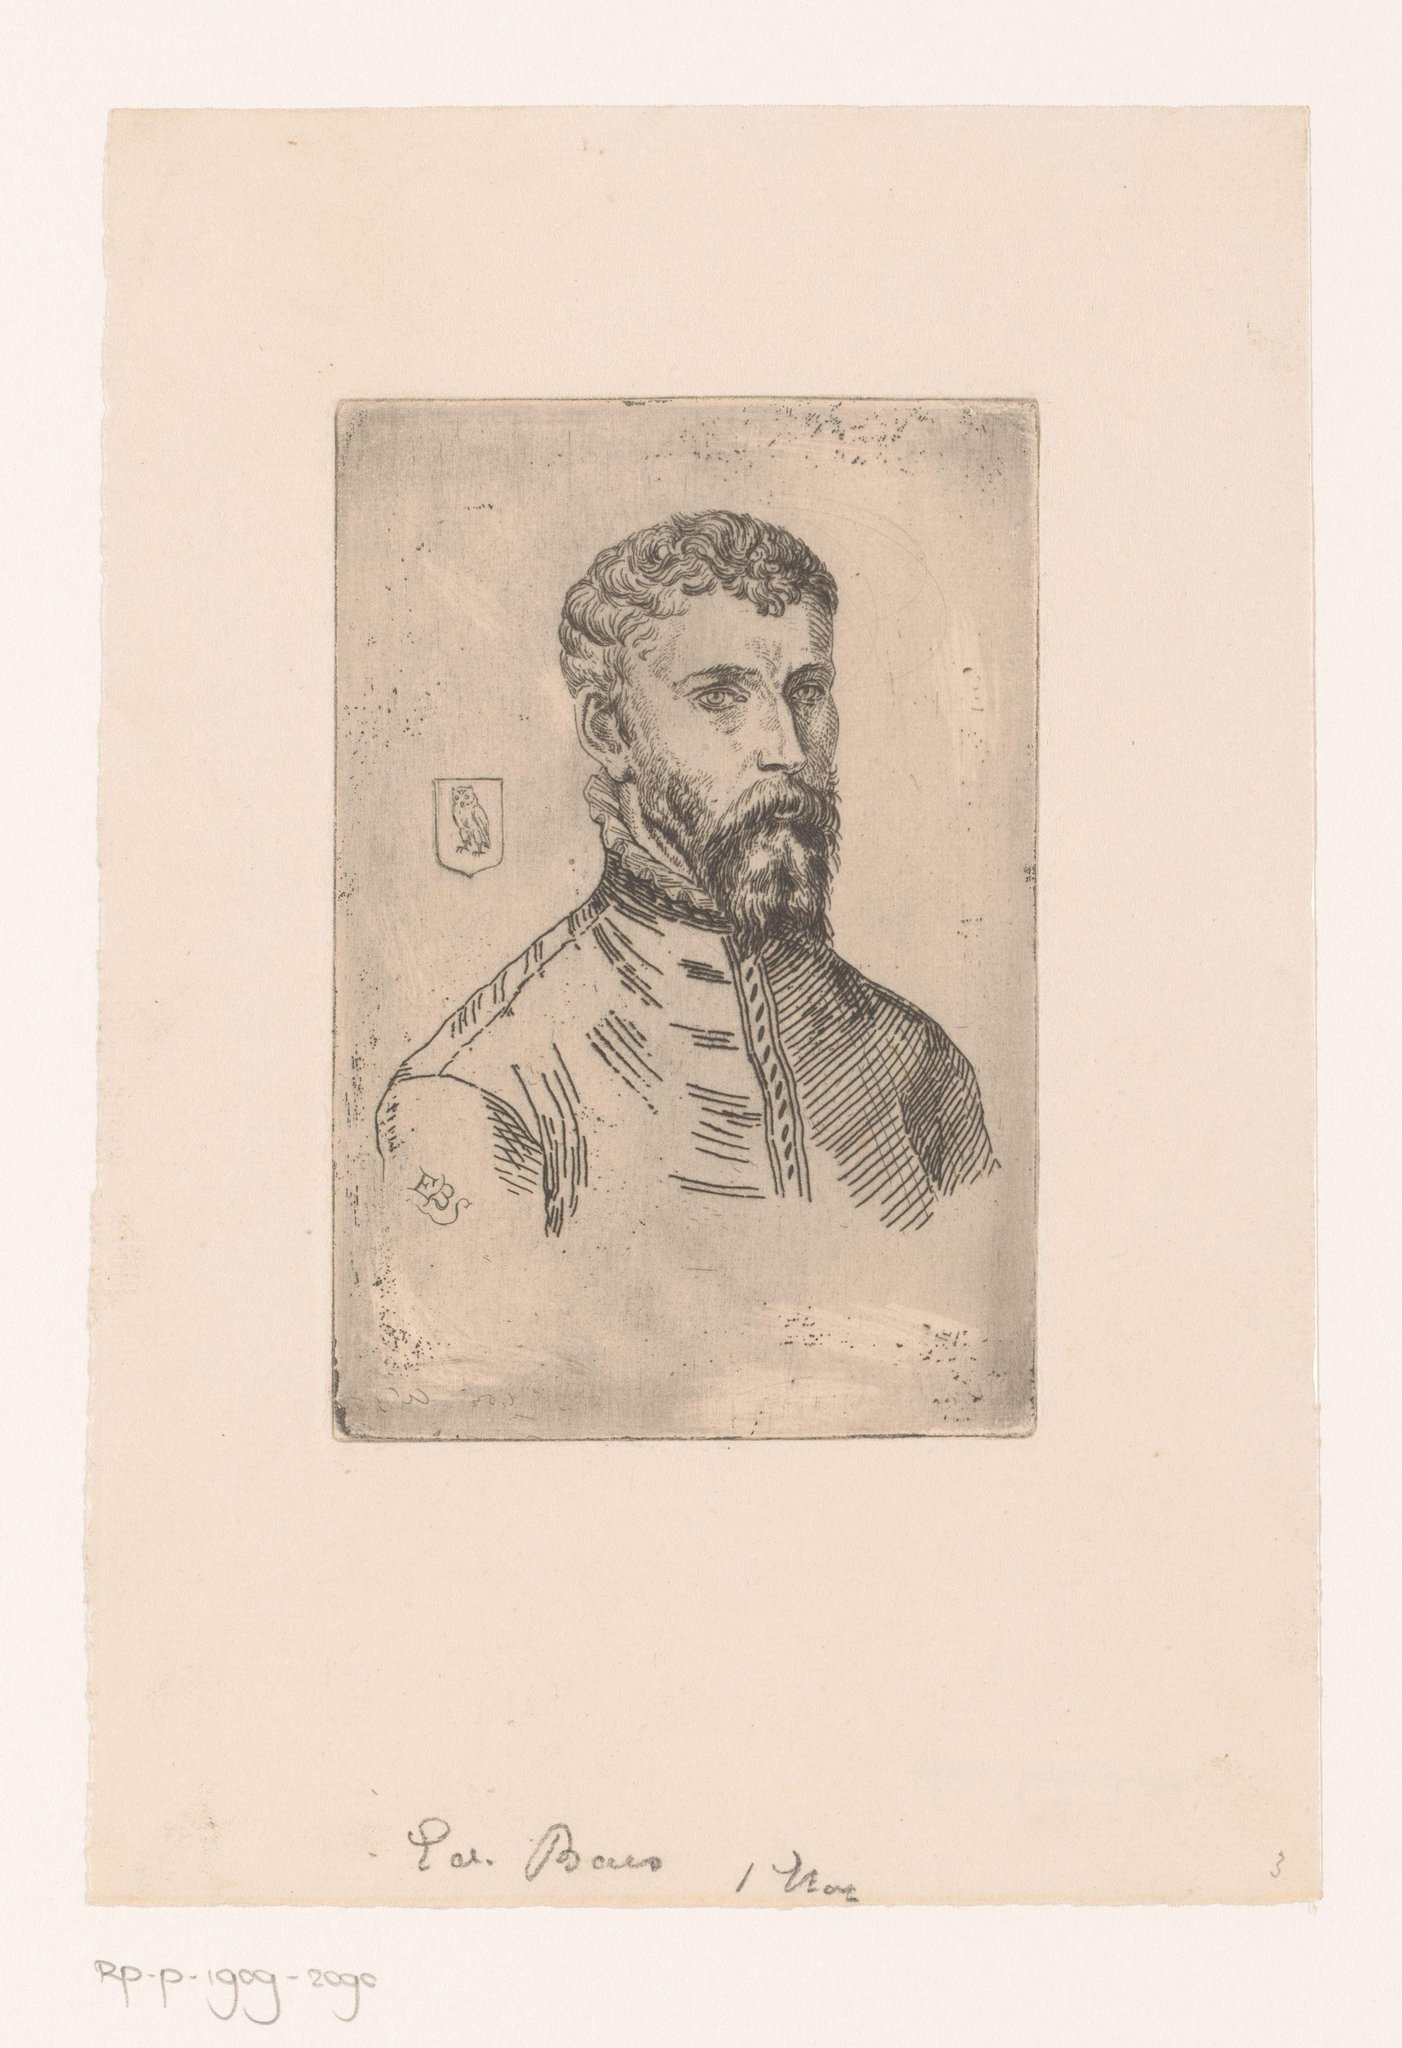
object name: print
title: Portret van Herri met de Bles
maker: edgar alfred baes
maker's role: print maker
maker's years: 1837-1909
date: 1847-1909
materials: paper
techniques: etching, intaglio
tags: print maker, herri met de bles, portrait, self-portrait of painter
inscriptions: collector's mark: Lugt 2228